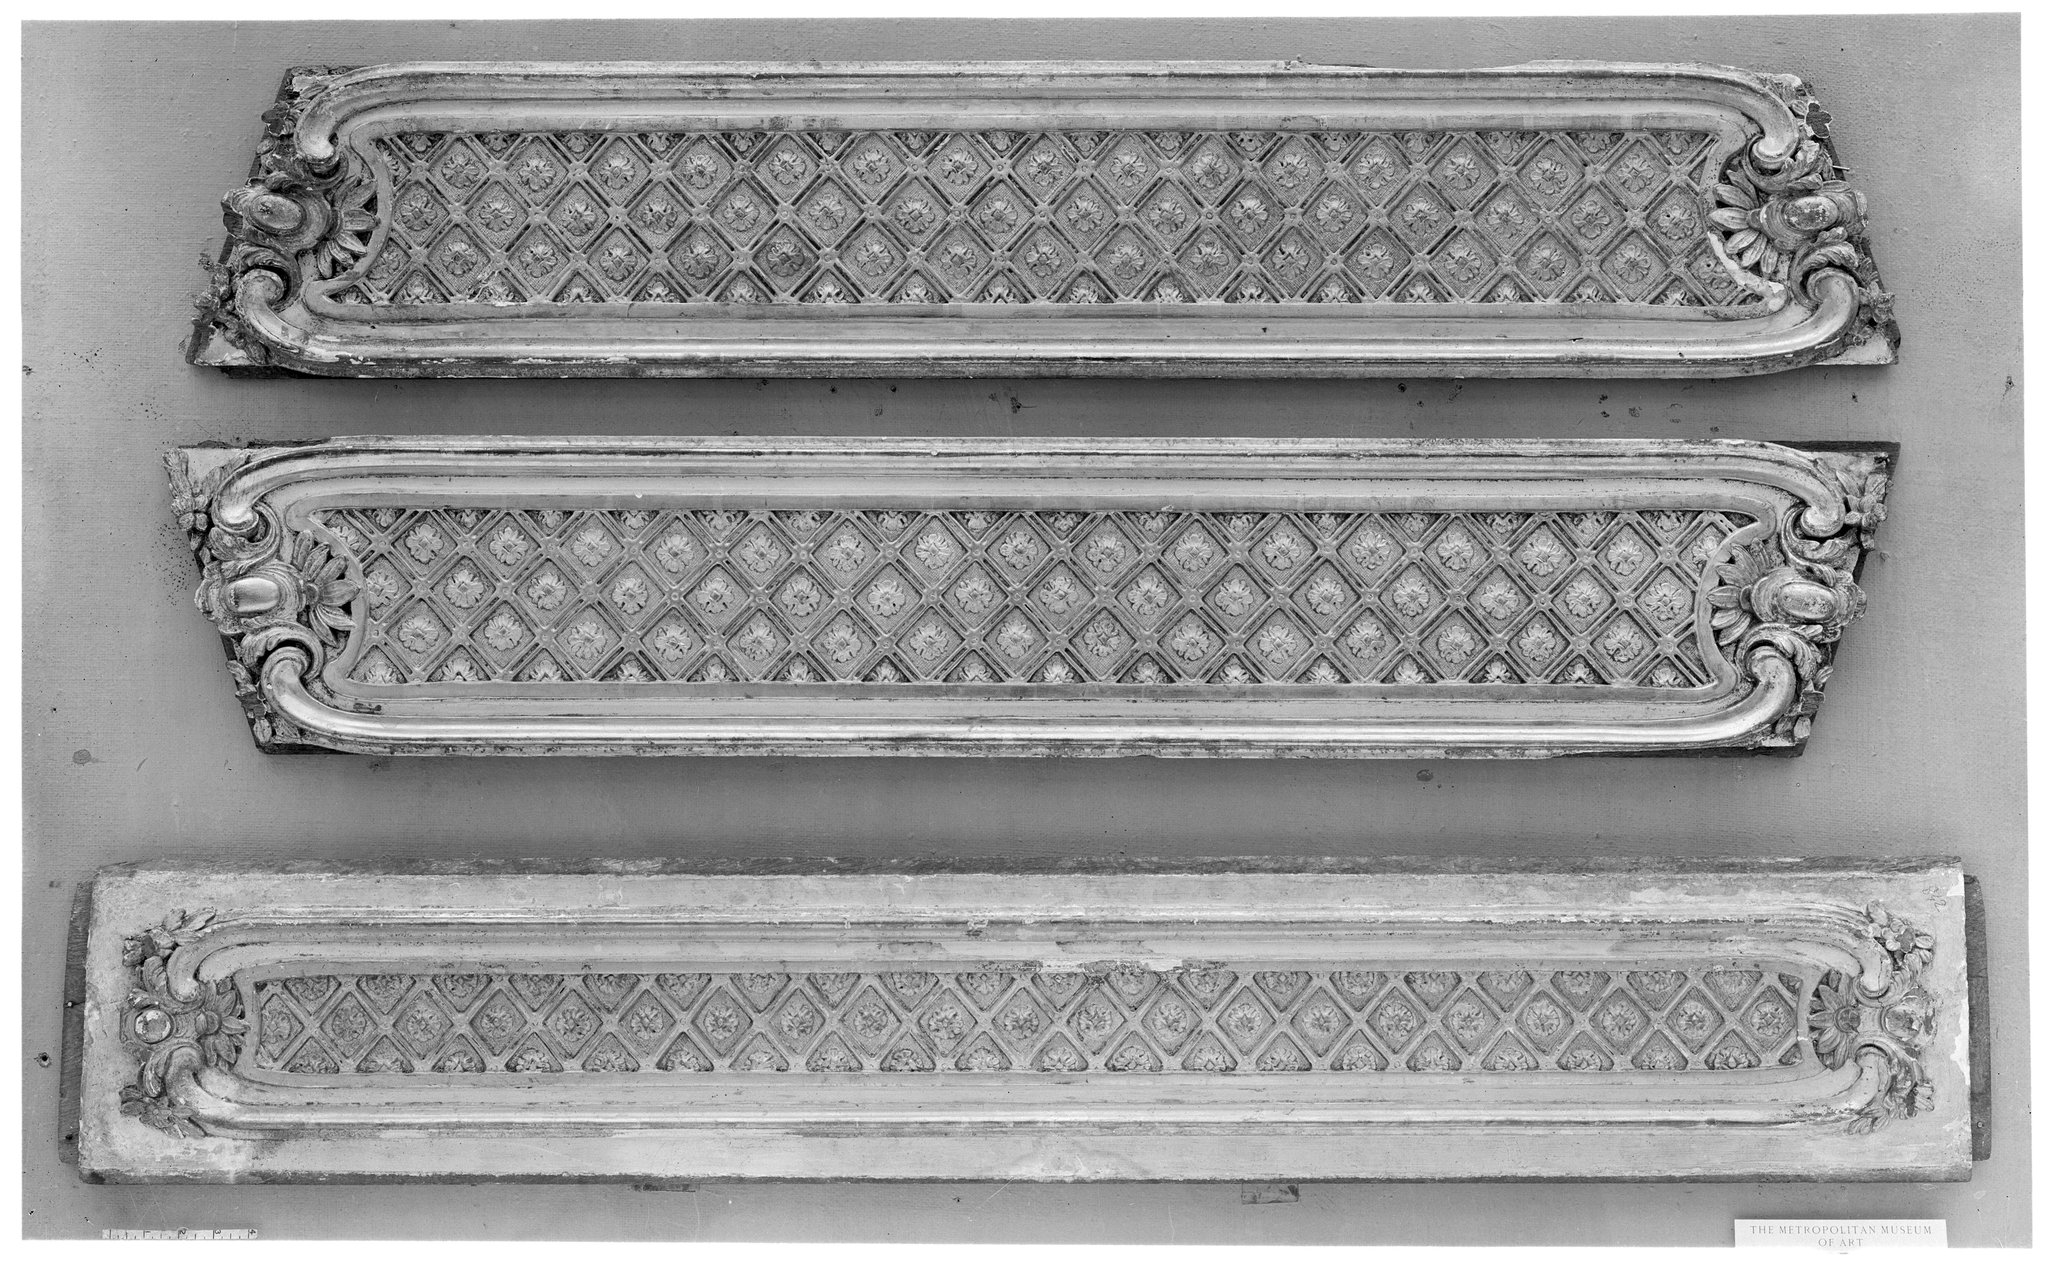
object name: panel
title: Set of panels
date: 1700-1735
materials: wood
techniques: carving, gilding